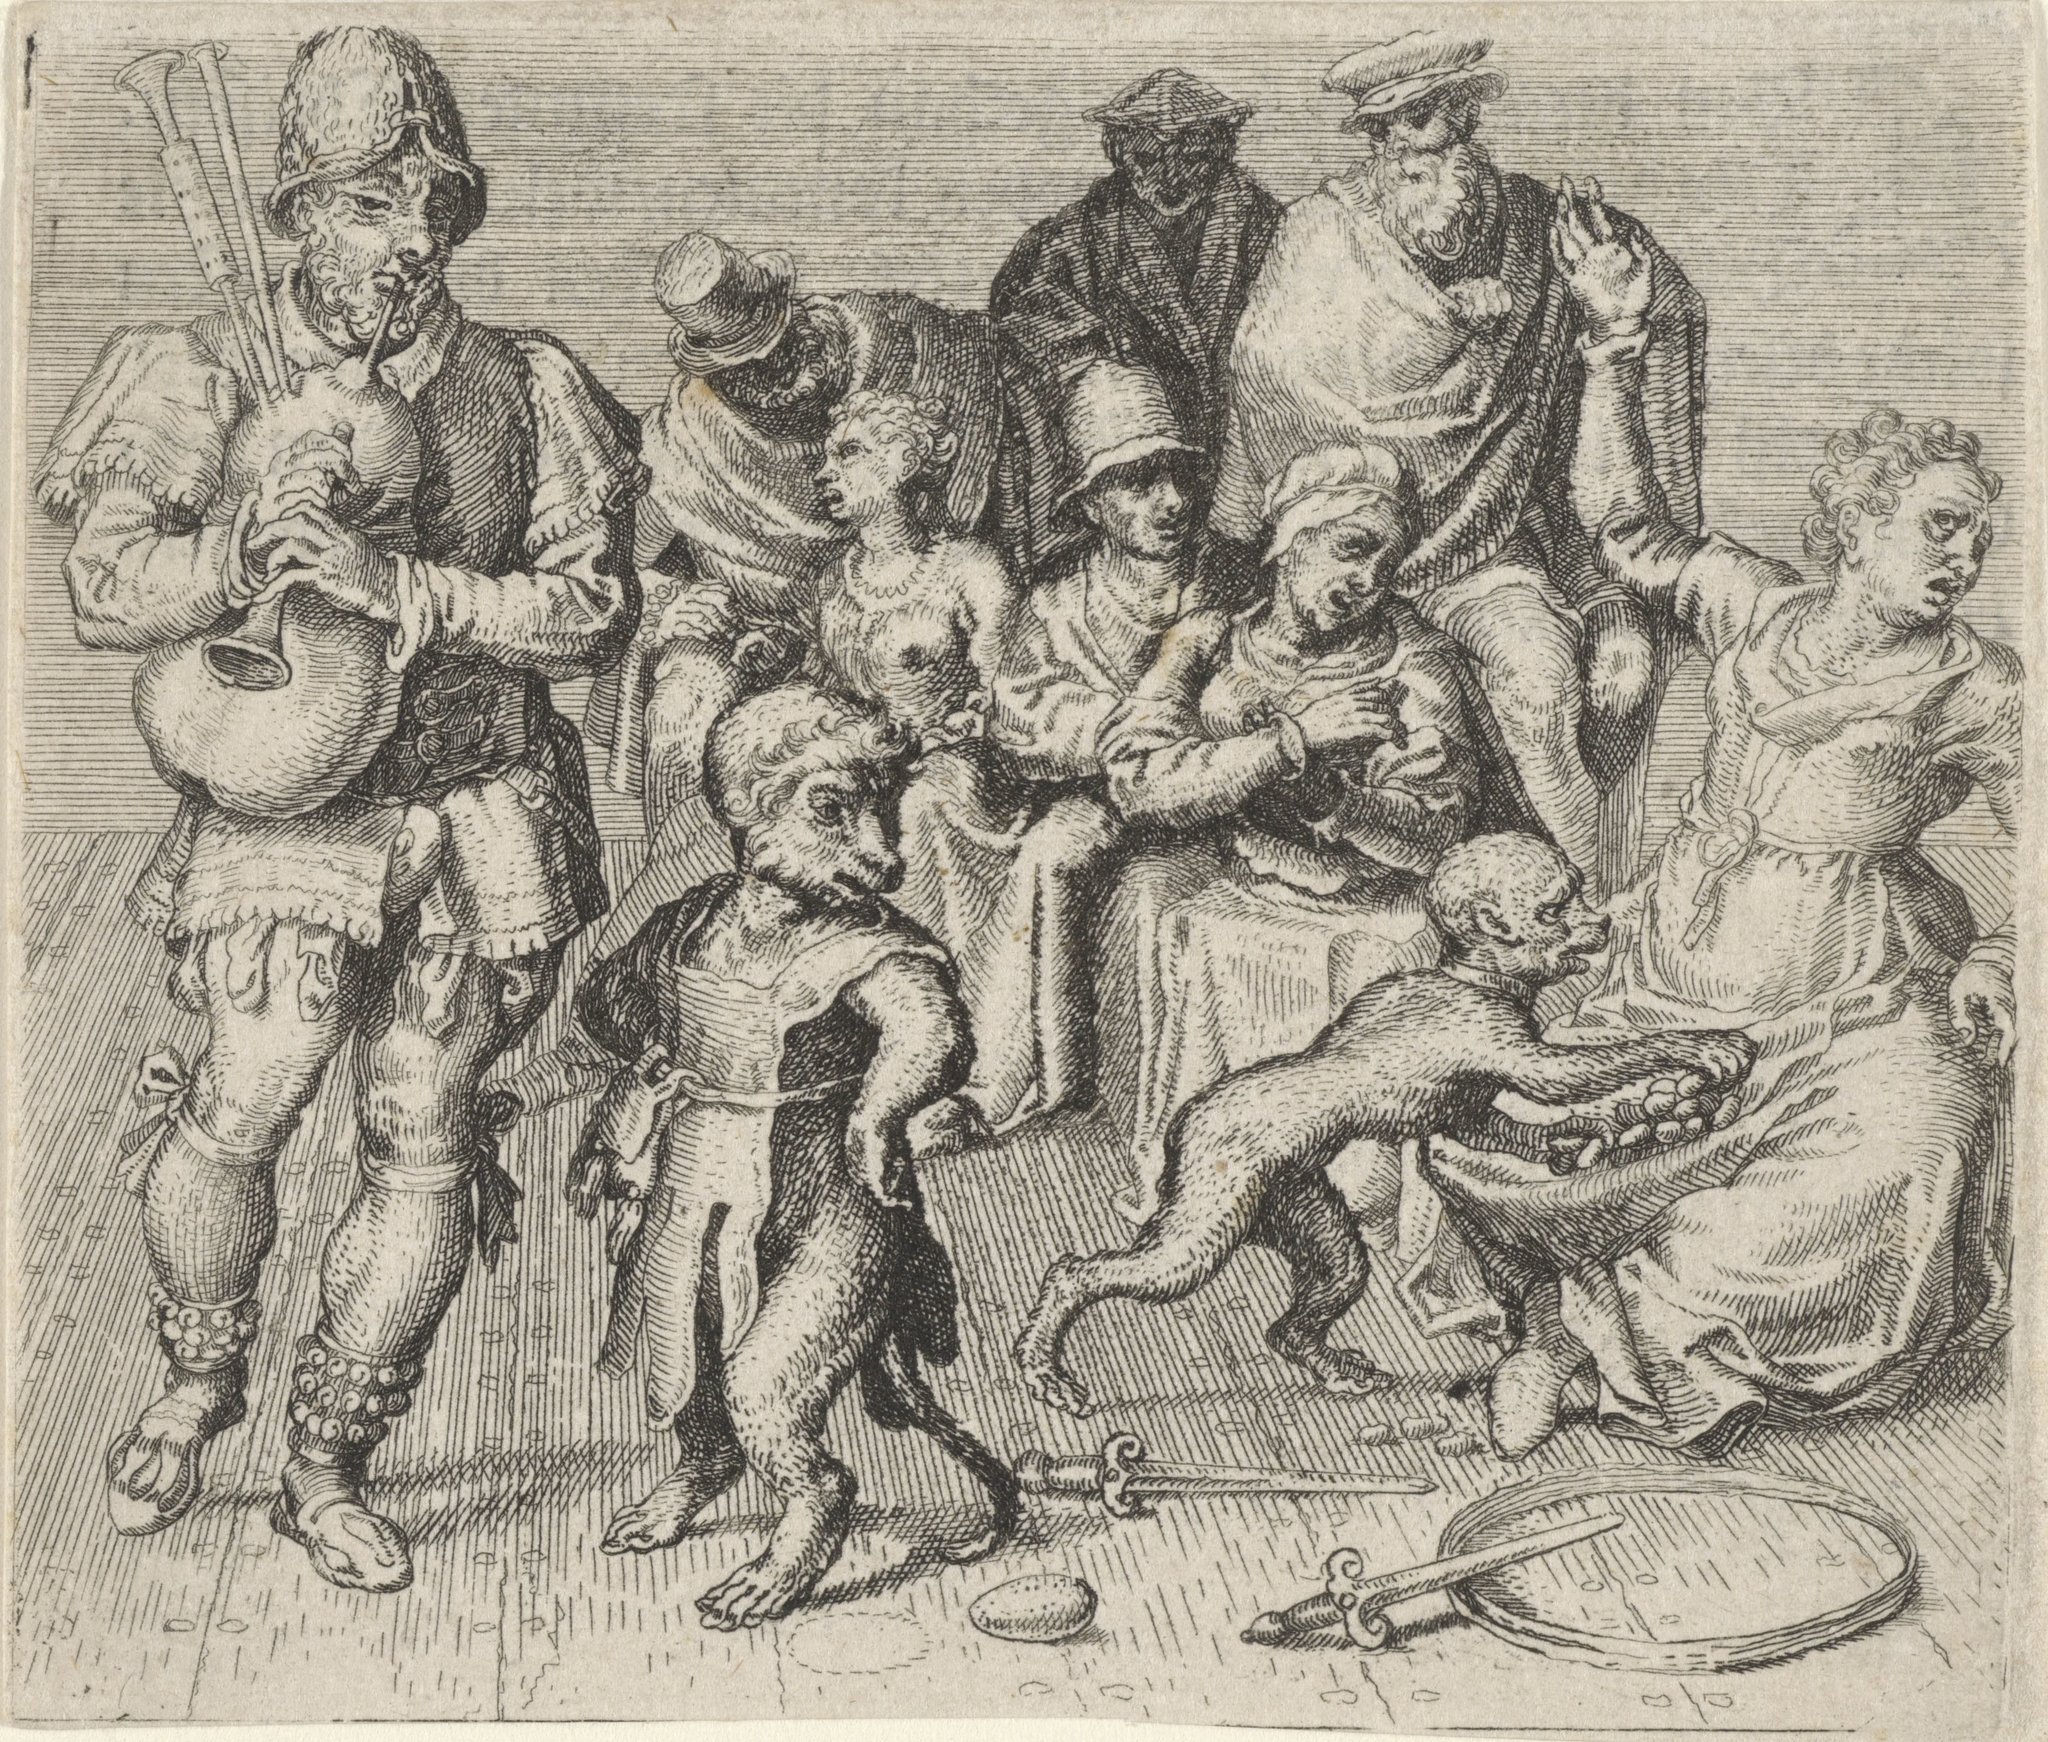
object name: print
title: Fabel van de aap en vrouw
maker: aegidius sadeler (ii)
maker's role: draughtsman, print maker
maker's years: 1568-1629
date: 1608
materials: paper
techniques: engraving, etching, letterpress printing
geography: prague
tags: bagpipe, musette (+ artist at work), listening to music, monkeys, apes, fruits: nuts, fables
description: Twee apen doen kunstjes voor een groep toeschouwers en worden begeleid door de muziek van een doedelzak. Een van de apen grijpt naar enkele noten die in de schoot van een vrouw liggen. De fabel beschrijft hoe twee apen voor een publiek dansen. Een van de apen springt plots op een vrouw en tracht de noten te grijpen die zij aan het eten is. Bij de daaropvolgende worsteling laat de vrouw haar naakte benen zien. De moraal van het verhaal leert dat niemand zijn ware natuur kan verbergen.